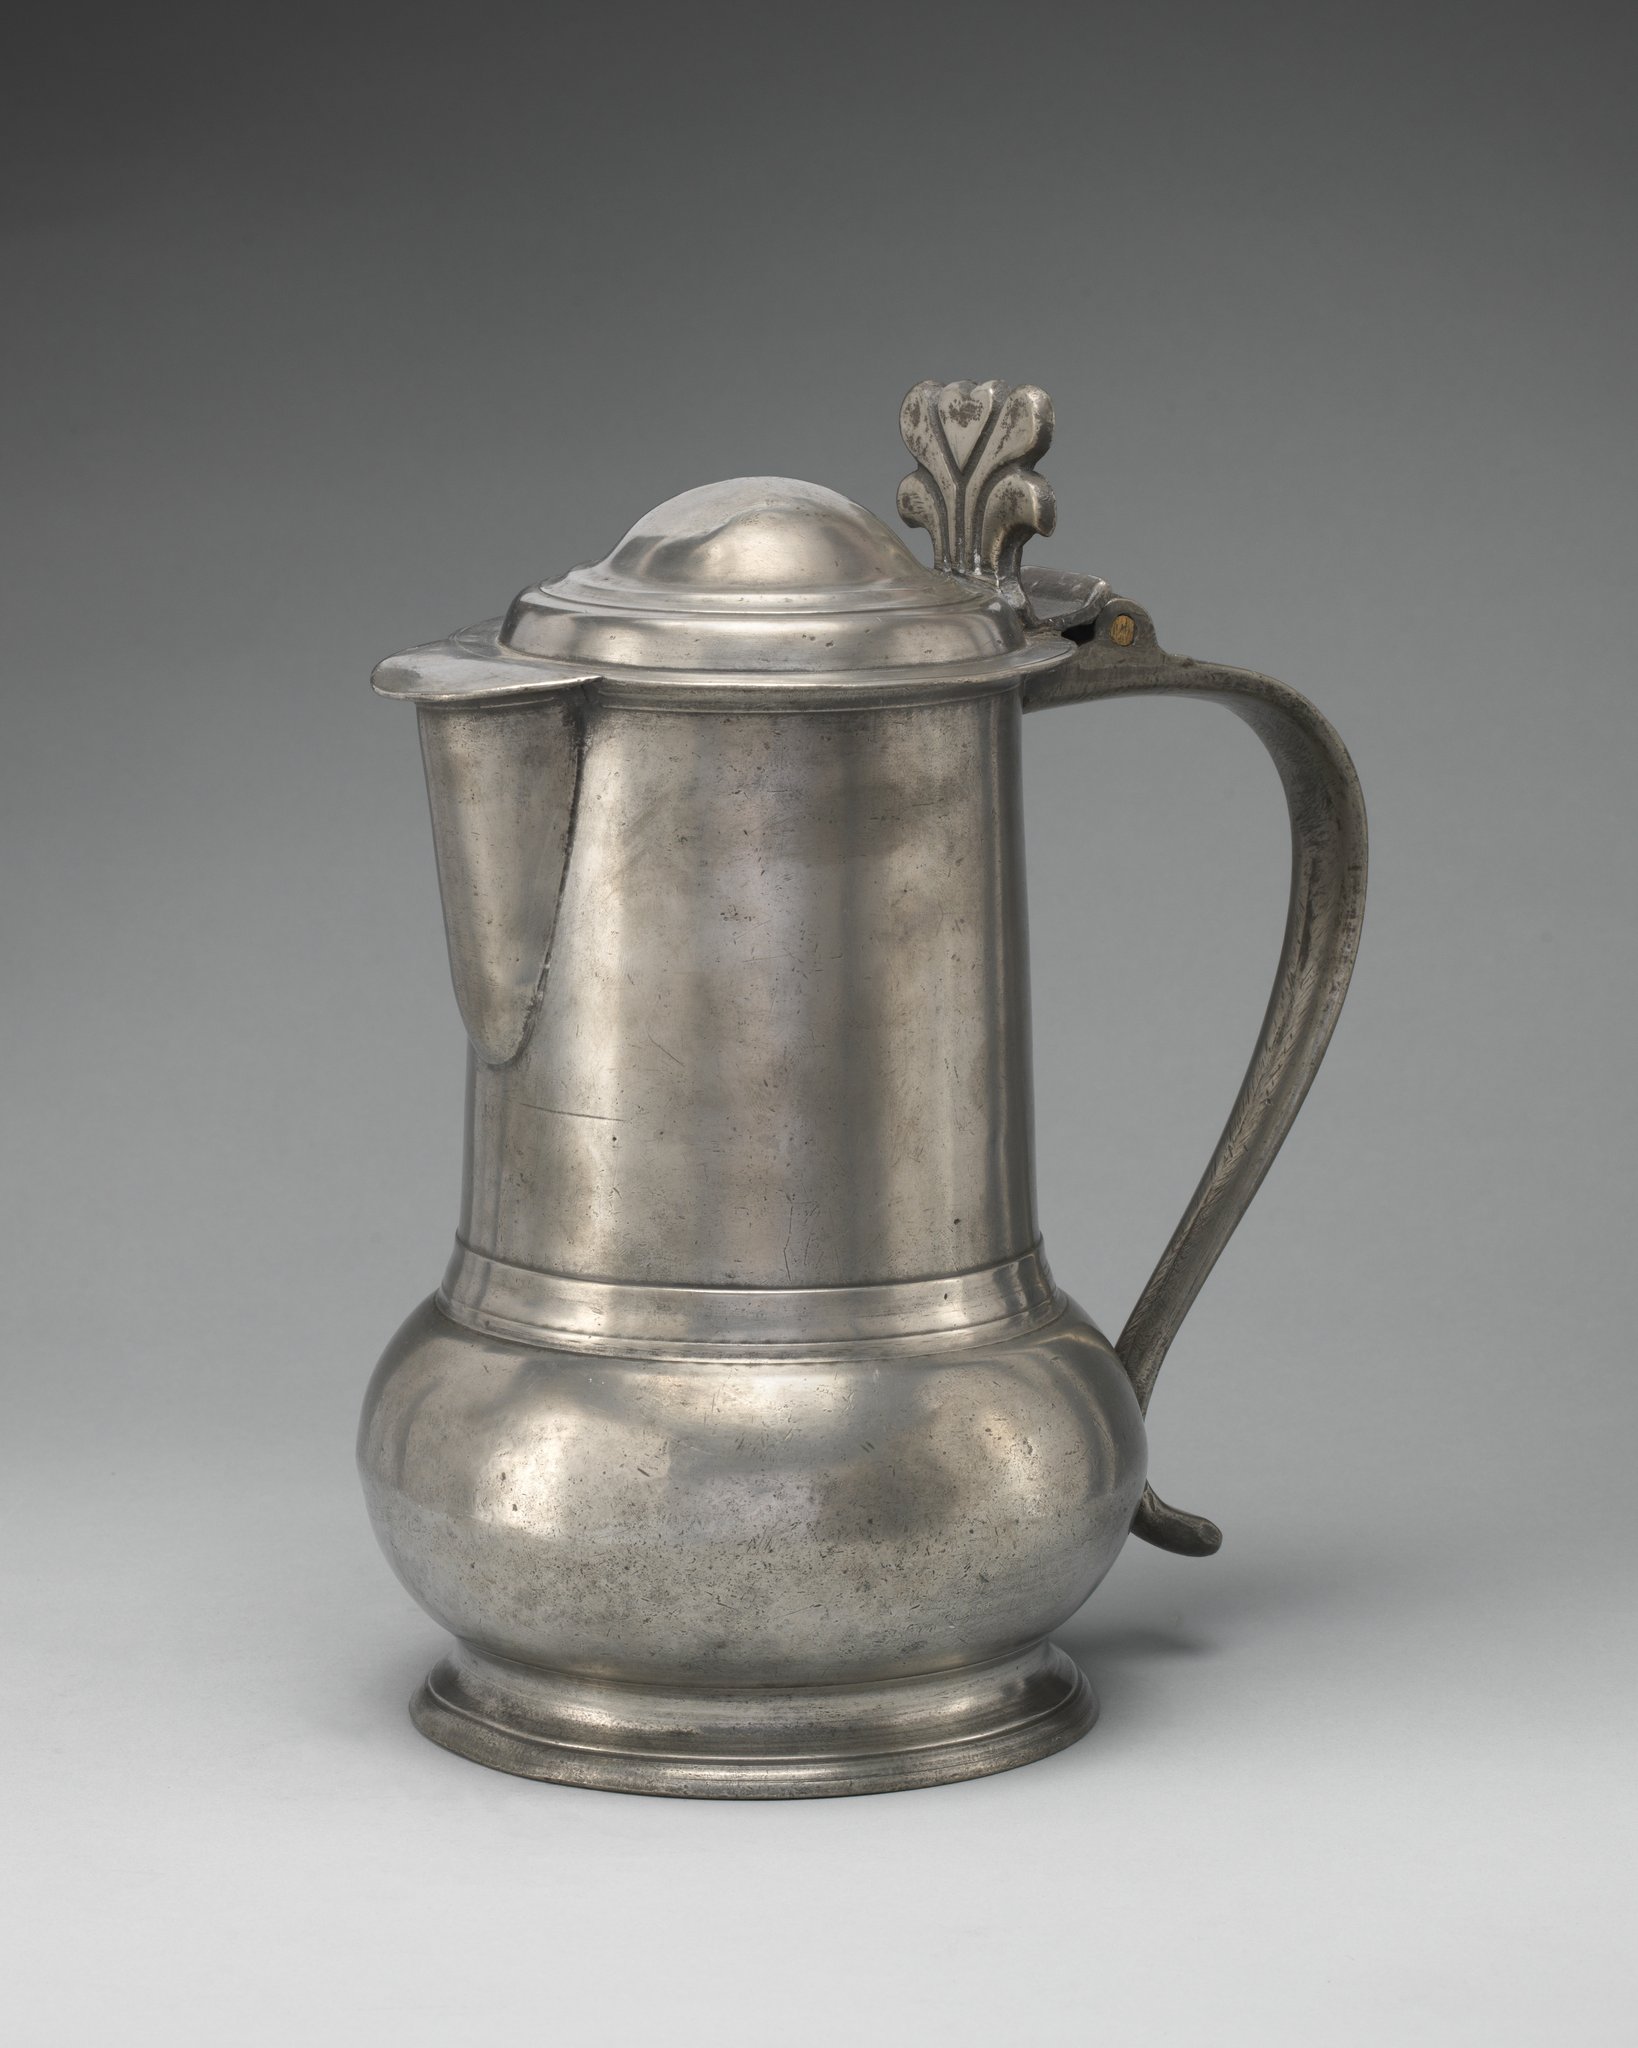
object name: church flagon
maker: edmund harvey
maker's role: maker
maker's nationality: british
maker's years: 1700-1750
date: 1725-1750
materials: pewter